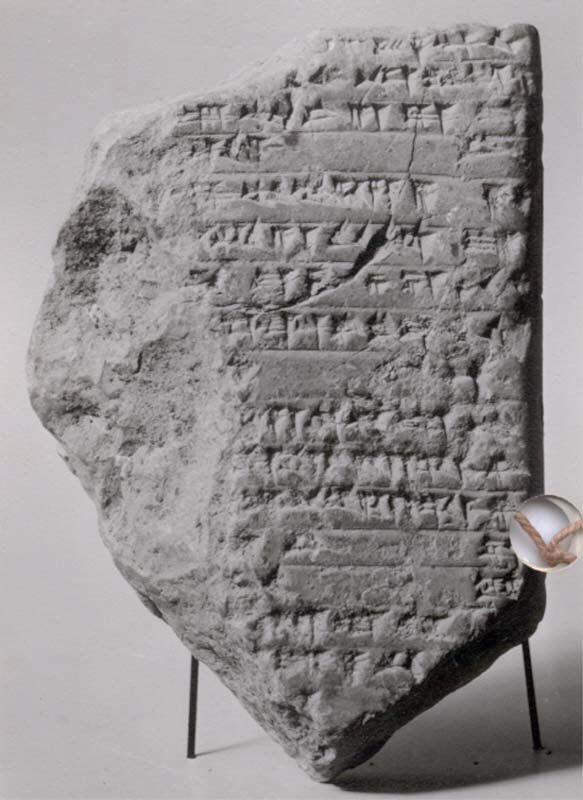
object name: cuneiform tablet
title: Cuneiform tablet: animal account, Ebabbar archive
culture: babylonian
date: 626-605 BCE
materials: clay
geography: mesopotamia